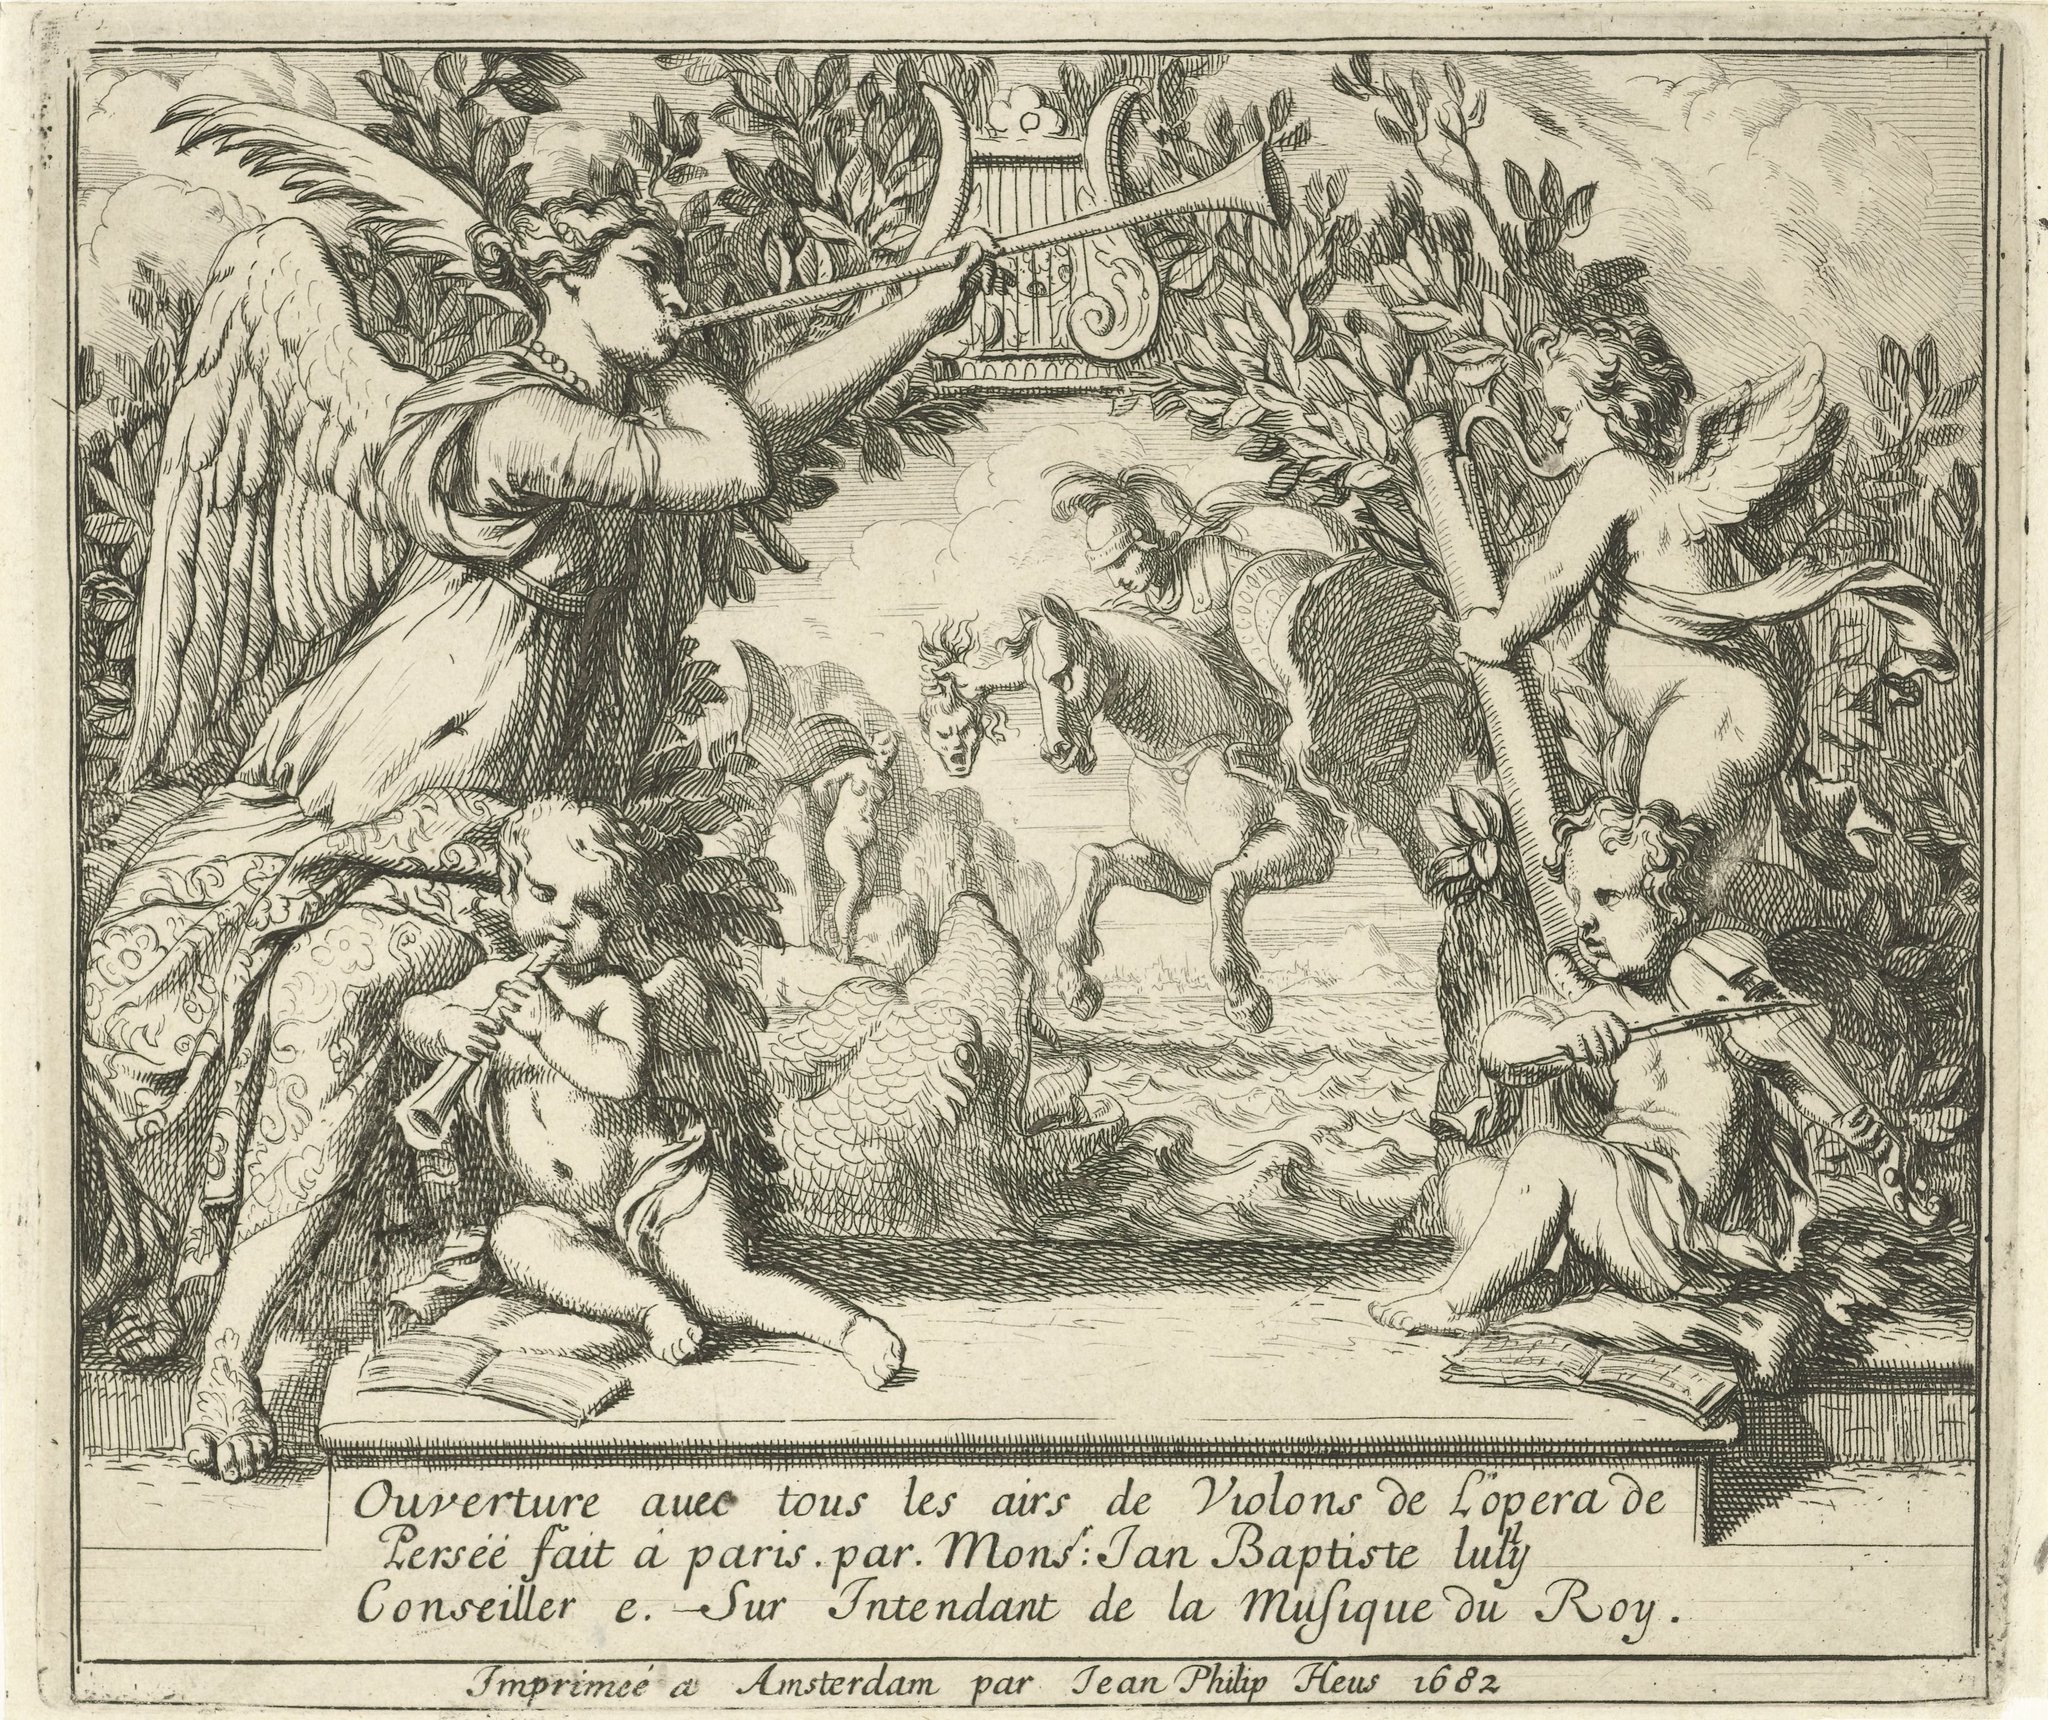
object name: print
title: Perseus met het hoofd van Medusa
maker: jean philip heus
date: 1682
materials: paper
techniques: etching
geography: amsterdam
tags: perseus shows andromeda the head of medusa mirrored in the water, fame; 'fama', 'fama buona', 'fama chiara' (ripa), cupids: 'amores', 'amoretti', 'putti'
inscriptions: collector's mark: Lugt 2228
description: Perseus vliegt te paard boven zee en houdt het afgehakte hoofd van Medusa aan de slangenharen vast. Voor hem ligt een zeemonster, links op de achtergrond staat Andromeda vastgeketend aan een rots. De mythologische scène is omlijst met gebladerte. Links hiervan blaast de Faam de bazuin, drie putti maken aan weerszijden muziek. Onderin de prent staat een drieregelig onderschrift in het Frans.